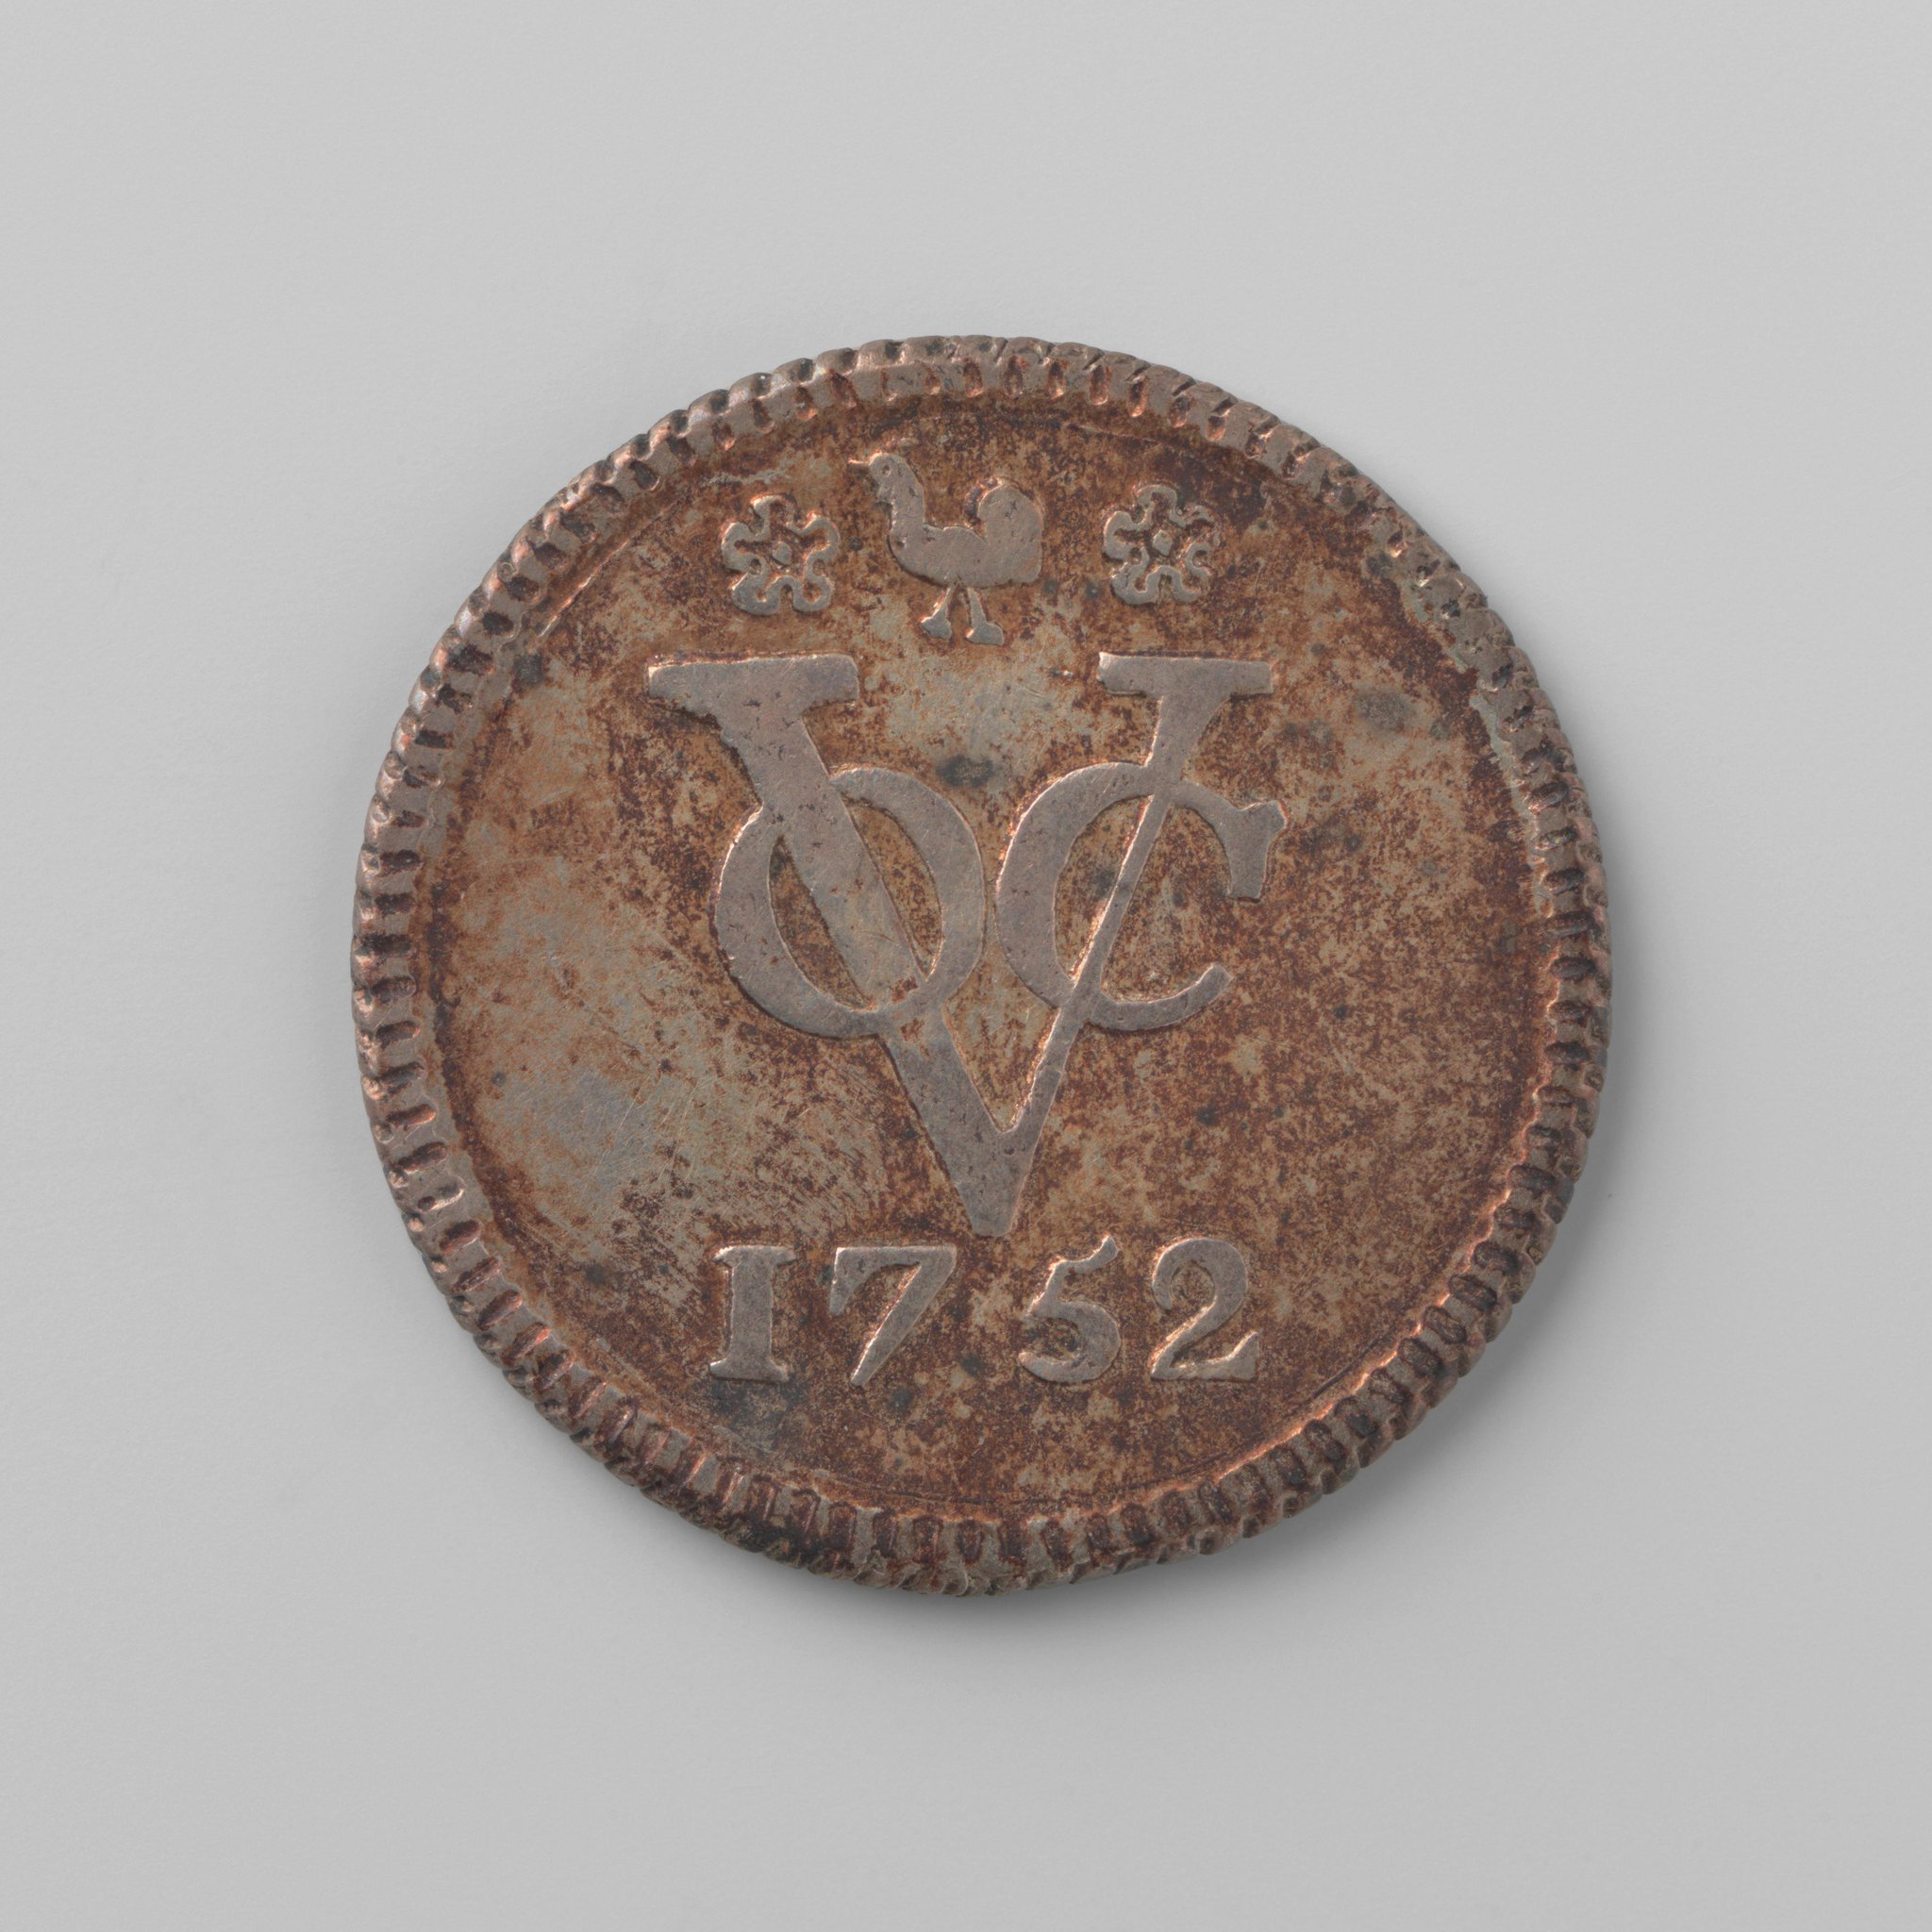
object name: coin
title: VOC, duit Westfriesland, 1752. Afslag in zilver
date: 1752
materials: silver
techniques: striking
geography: hoorn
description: Zilveren munt. Voorzijde: gekroond ingebogen wapenschild van Westfriesland. Keerzijde: monogram van de VOC, waarboven muntmeesterteken en waaronder jaartal. Kabelrand.